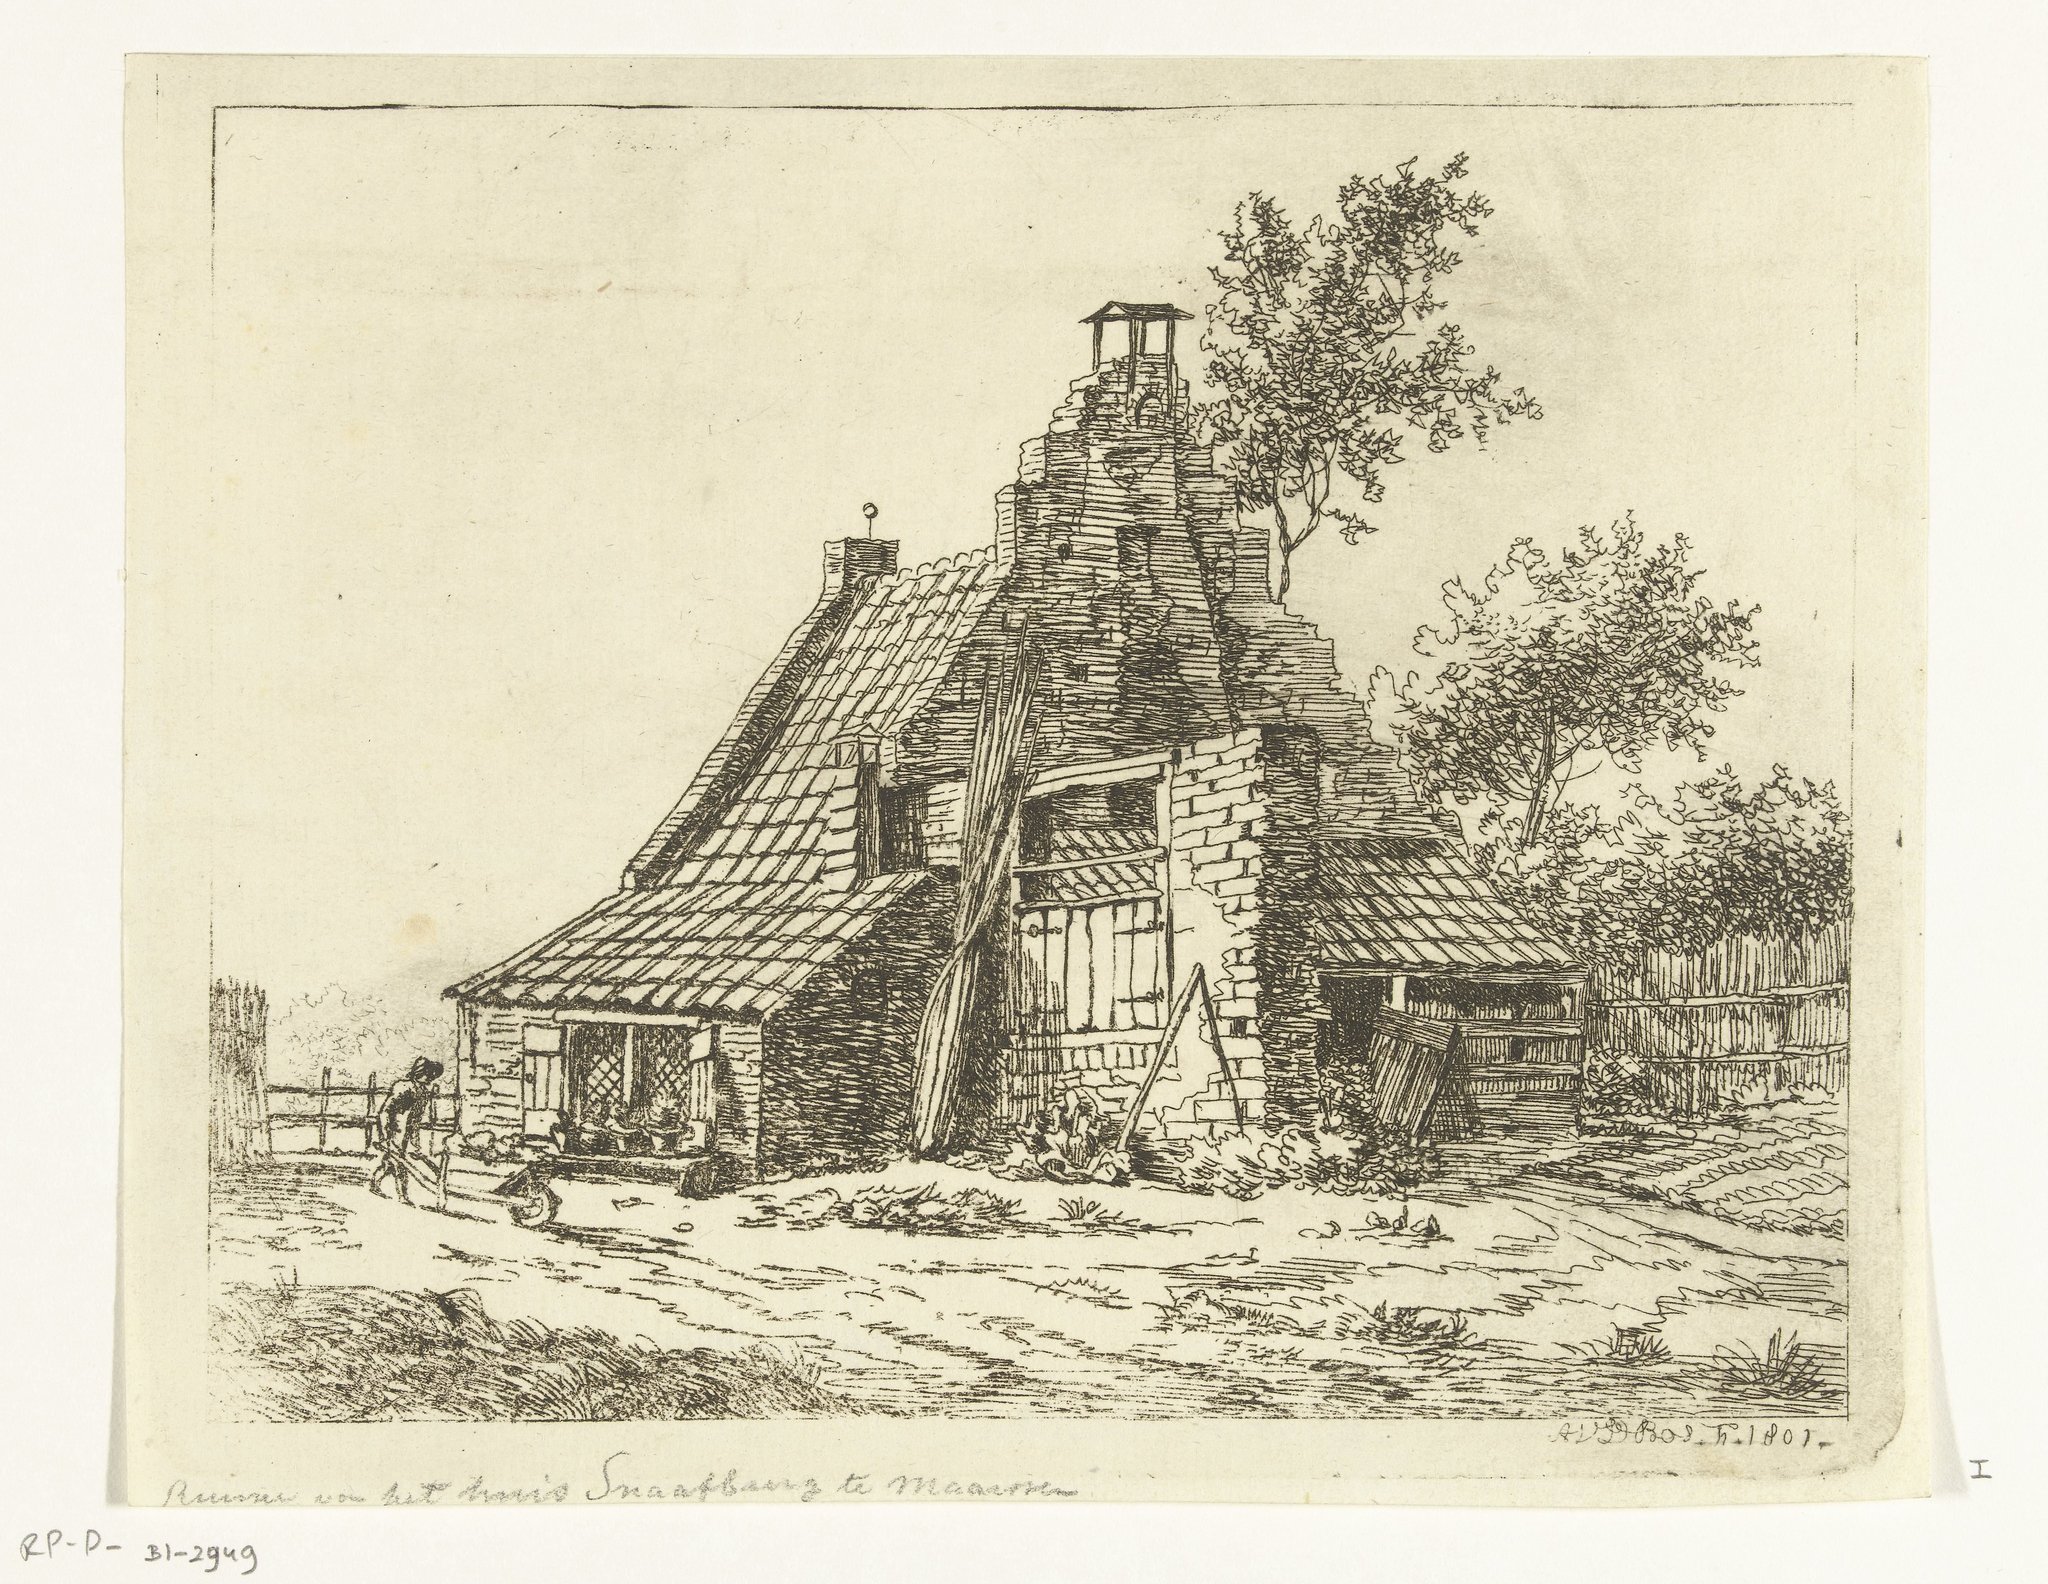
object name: print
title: Ruïne van het huis Snaatburg te Maarssen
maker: anthonie van den bos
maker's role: draughtsman, print maker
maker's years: 1763-1838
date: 1801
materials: paper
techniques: etching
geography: netherlands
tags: ruin of a dwelling, house, castle, etc.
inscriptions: collector's mark: Lugt 2228